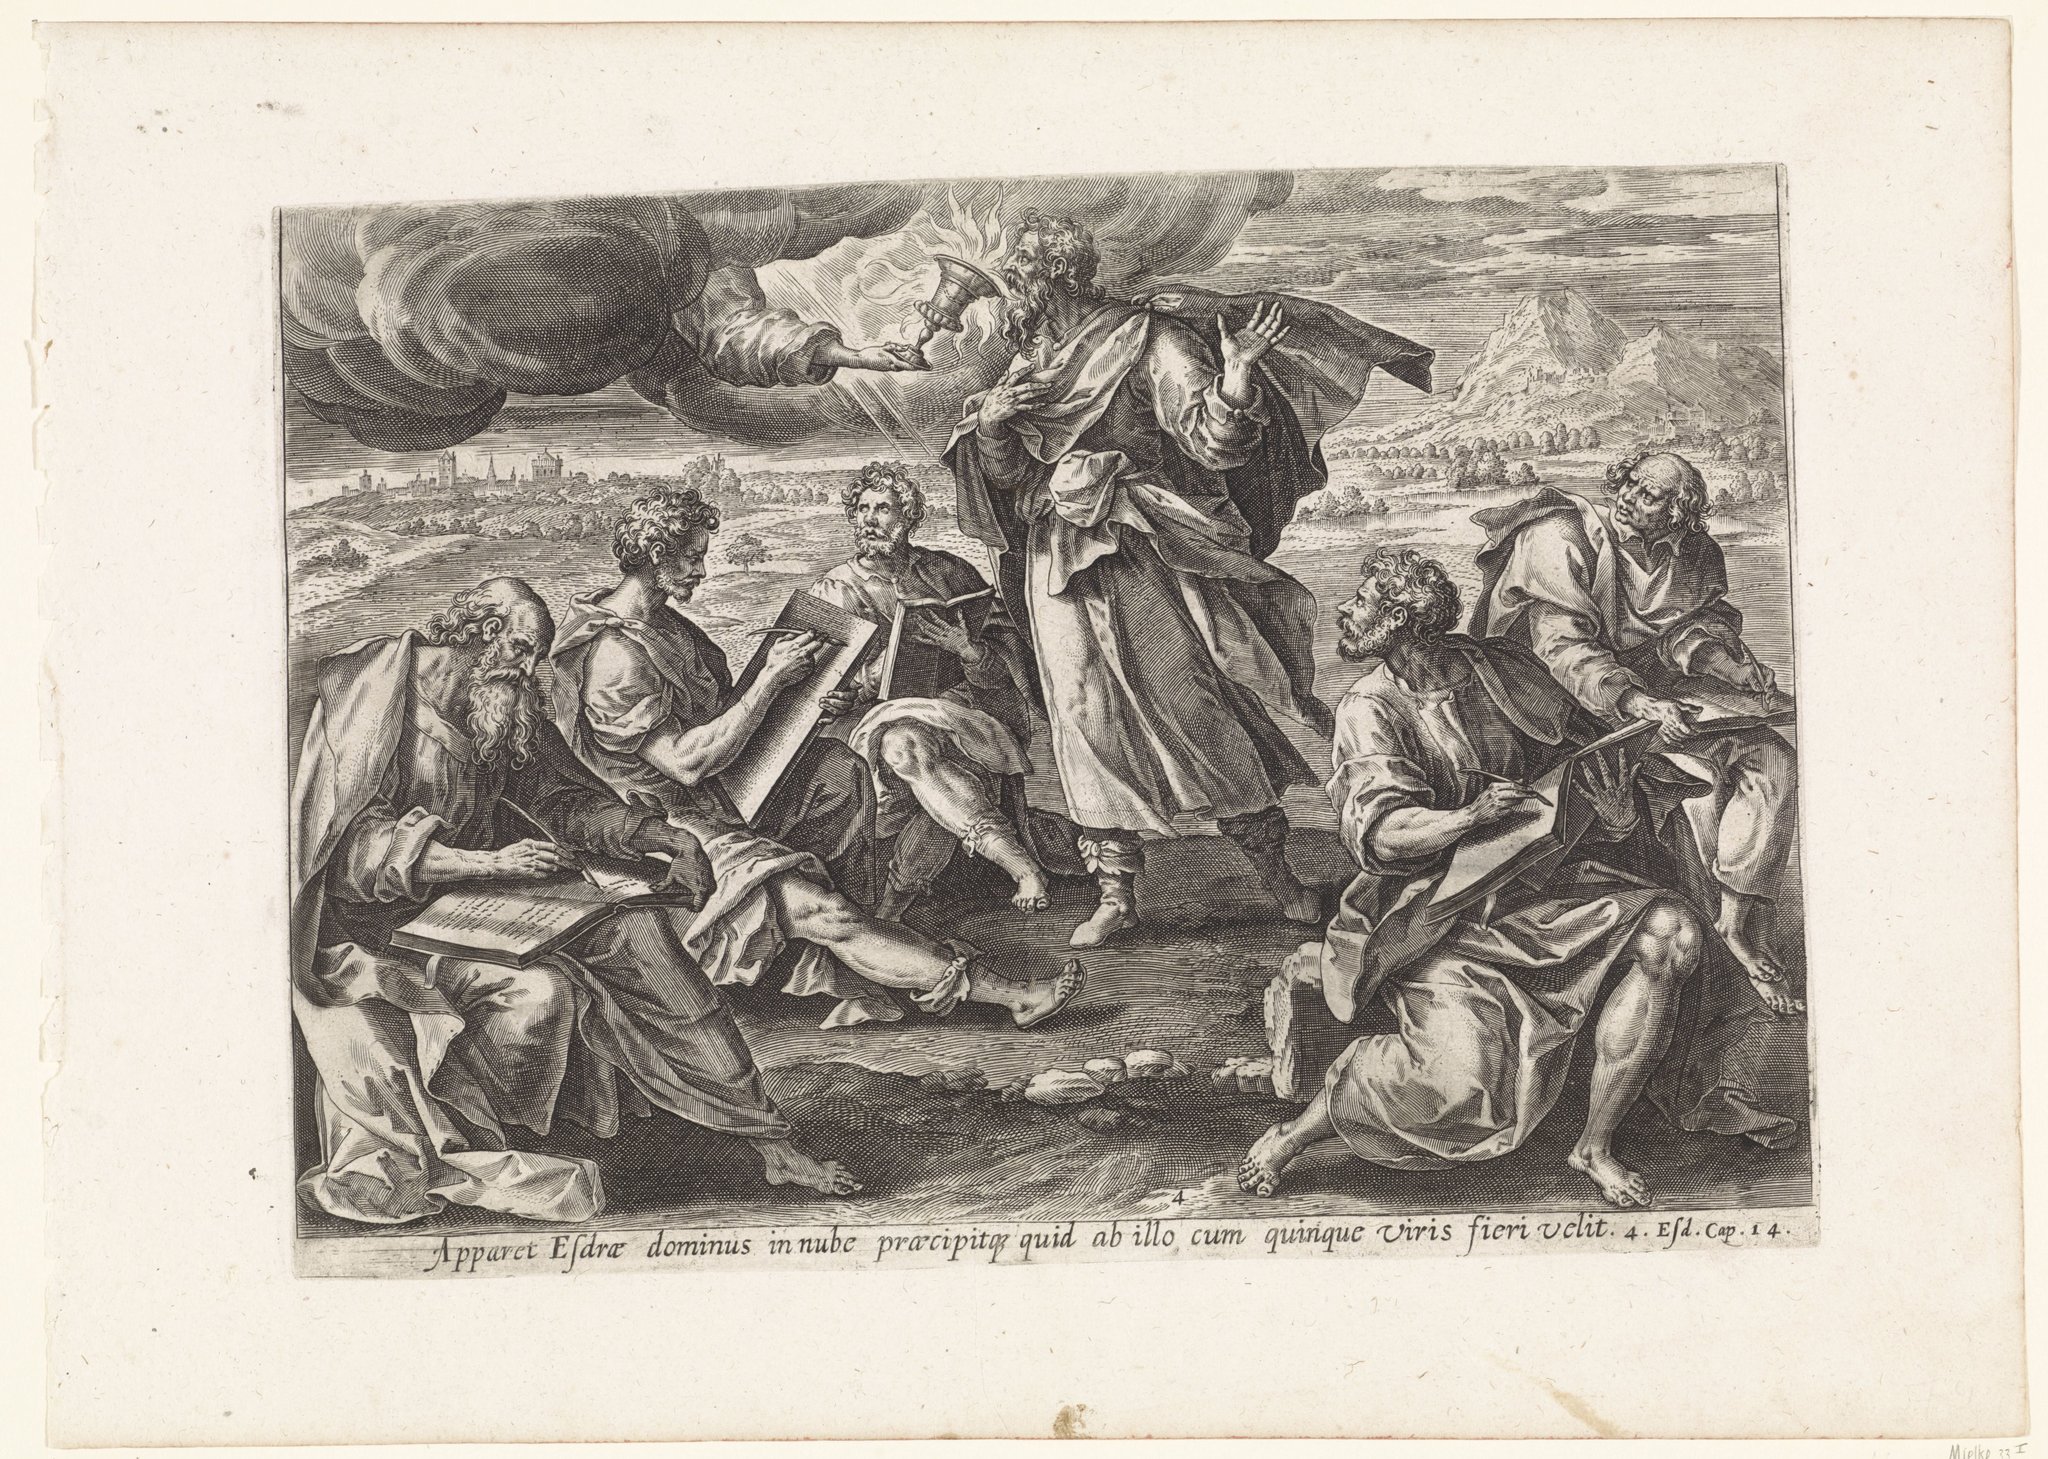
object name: print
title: Ezra drinkt de beker van kennis en wijsheid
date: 1585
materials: paper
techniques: engraving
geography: antwerp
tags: other scenes from ezra and esdras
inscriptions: collector's mark: Lugt 2760, collector's mark: Lugt 2228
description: Ezra is met vijf mannen naar het veld gegaan en krijgt daar van God een vurige beker aangeboden waaruit hij drinkt. Dit is de beker van kennis en wijsheid. De vijf mannen schrijven de woorden op die Ezra hierna zegt. Onder de voorstelling een verwijzing in het Latijn naar de apocriefe Bijbeltekst in 4 Ezra 14.